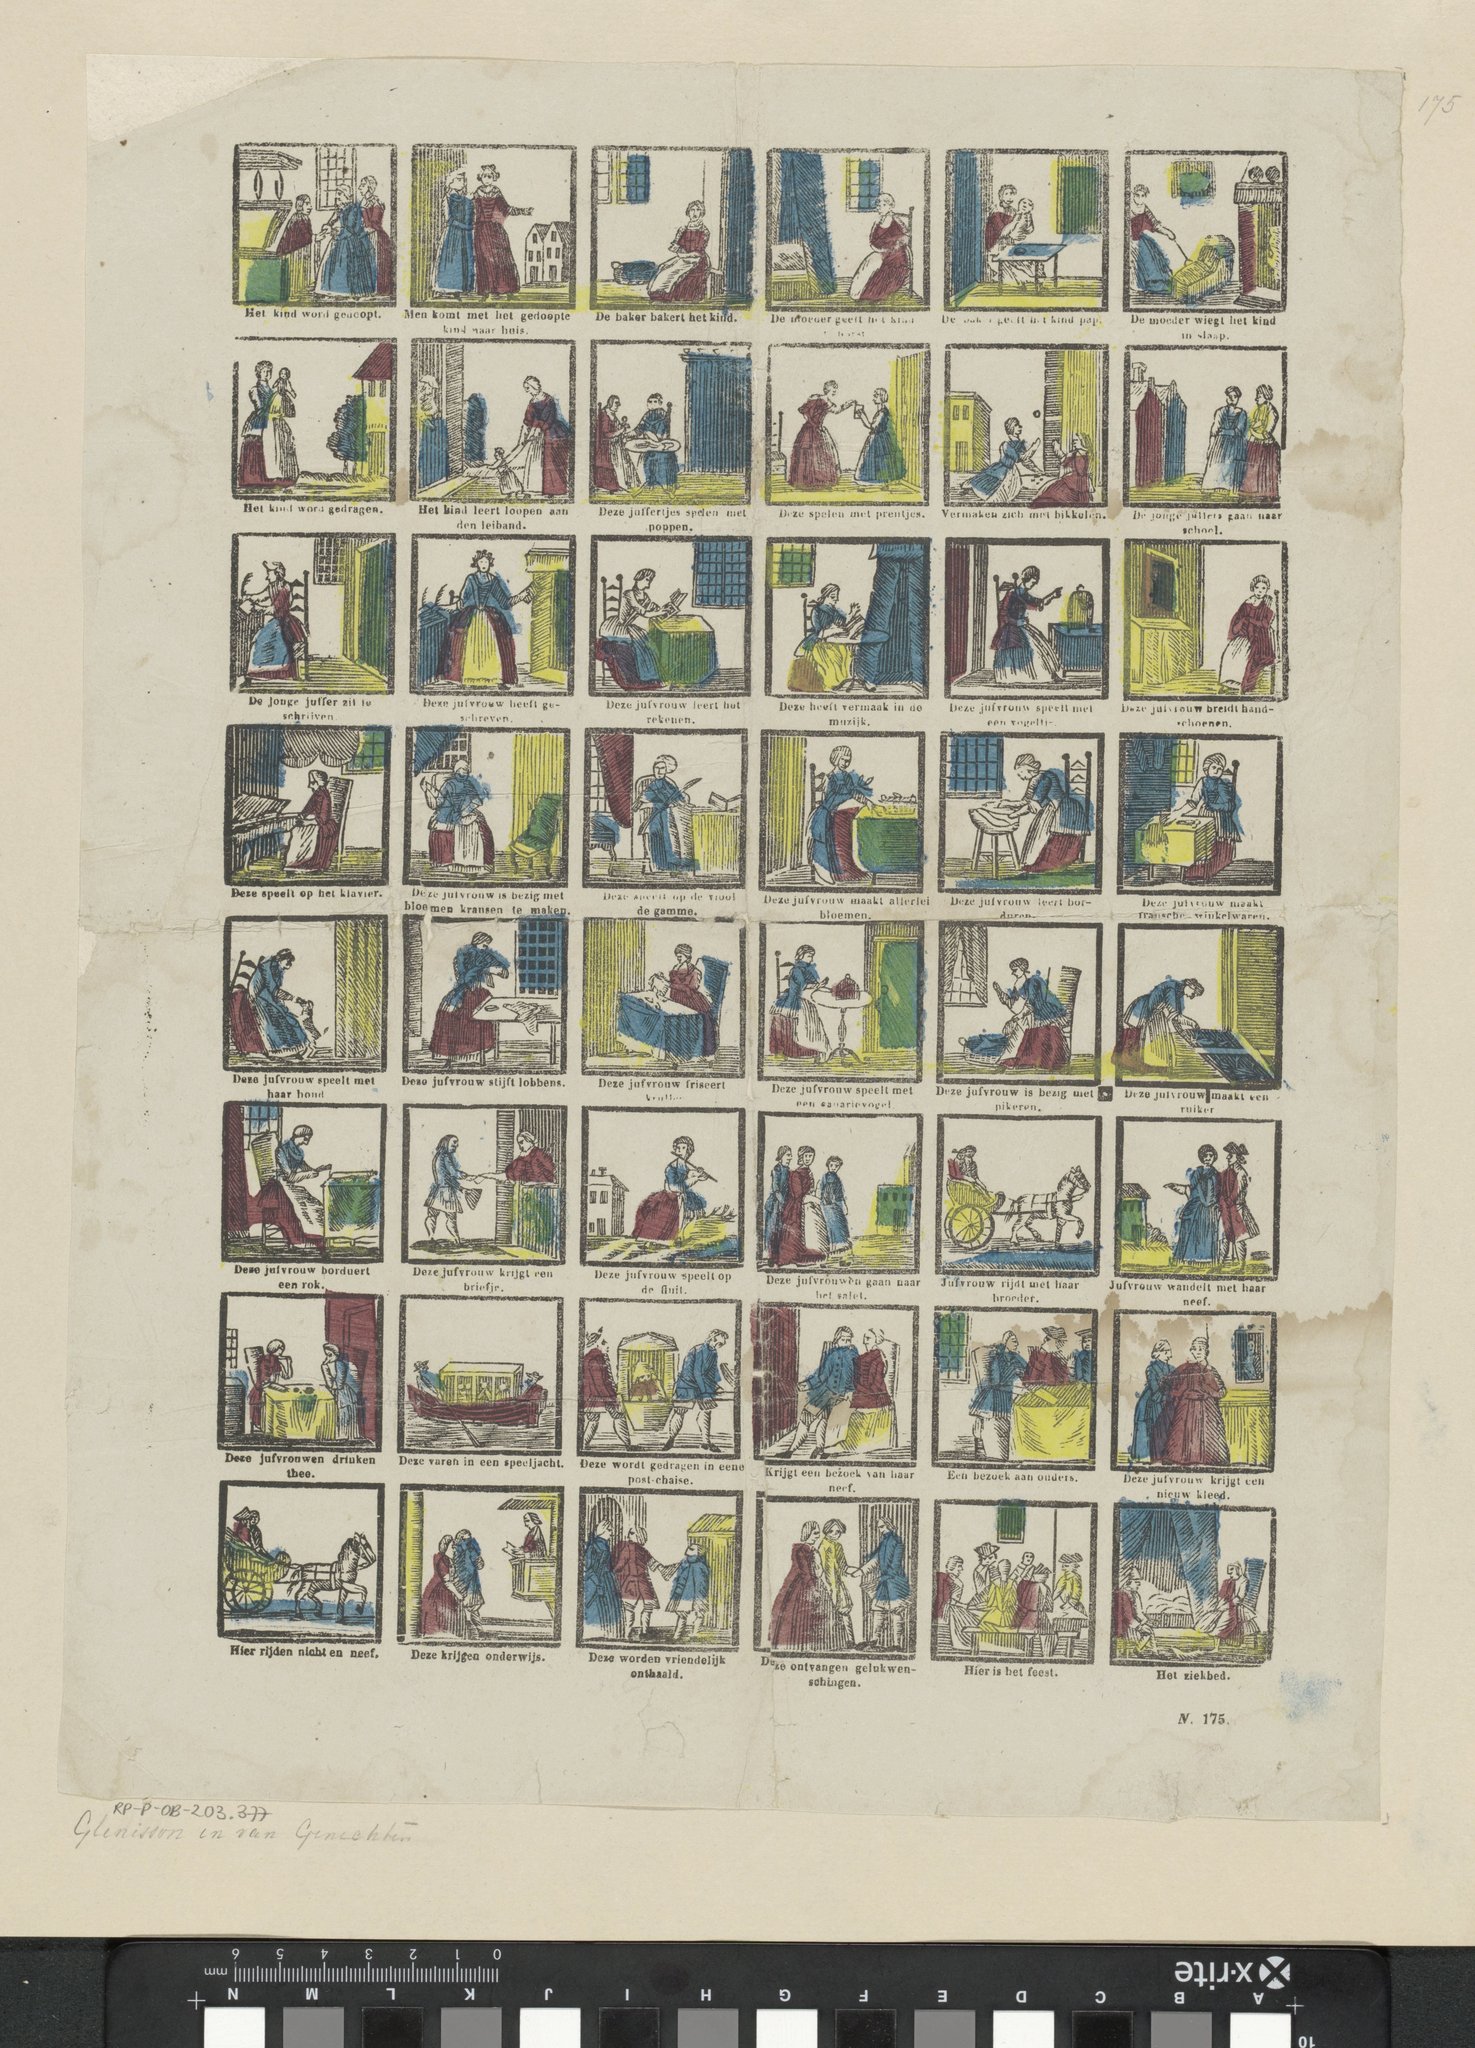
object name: popular print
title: Leven van een vrouw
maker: Anonymous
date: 1833-1900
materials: paper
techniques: colour, letterpress printing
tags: human life divided into stages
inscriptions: collector's mark: Lugt 2760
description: Blad met 48 voorstellingen van de verschillende stadia in het leven van een vrouw, van doop tot huwelijk. Onder elke afbeelding een onderschrift. Genummerd rechtsonder: N. 175.